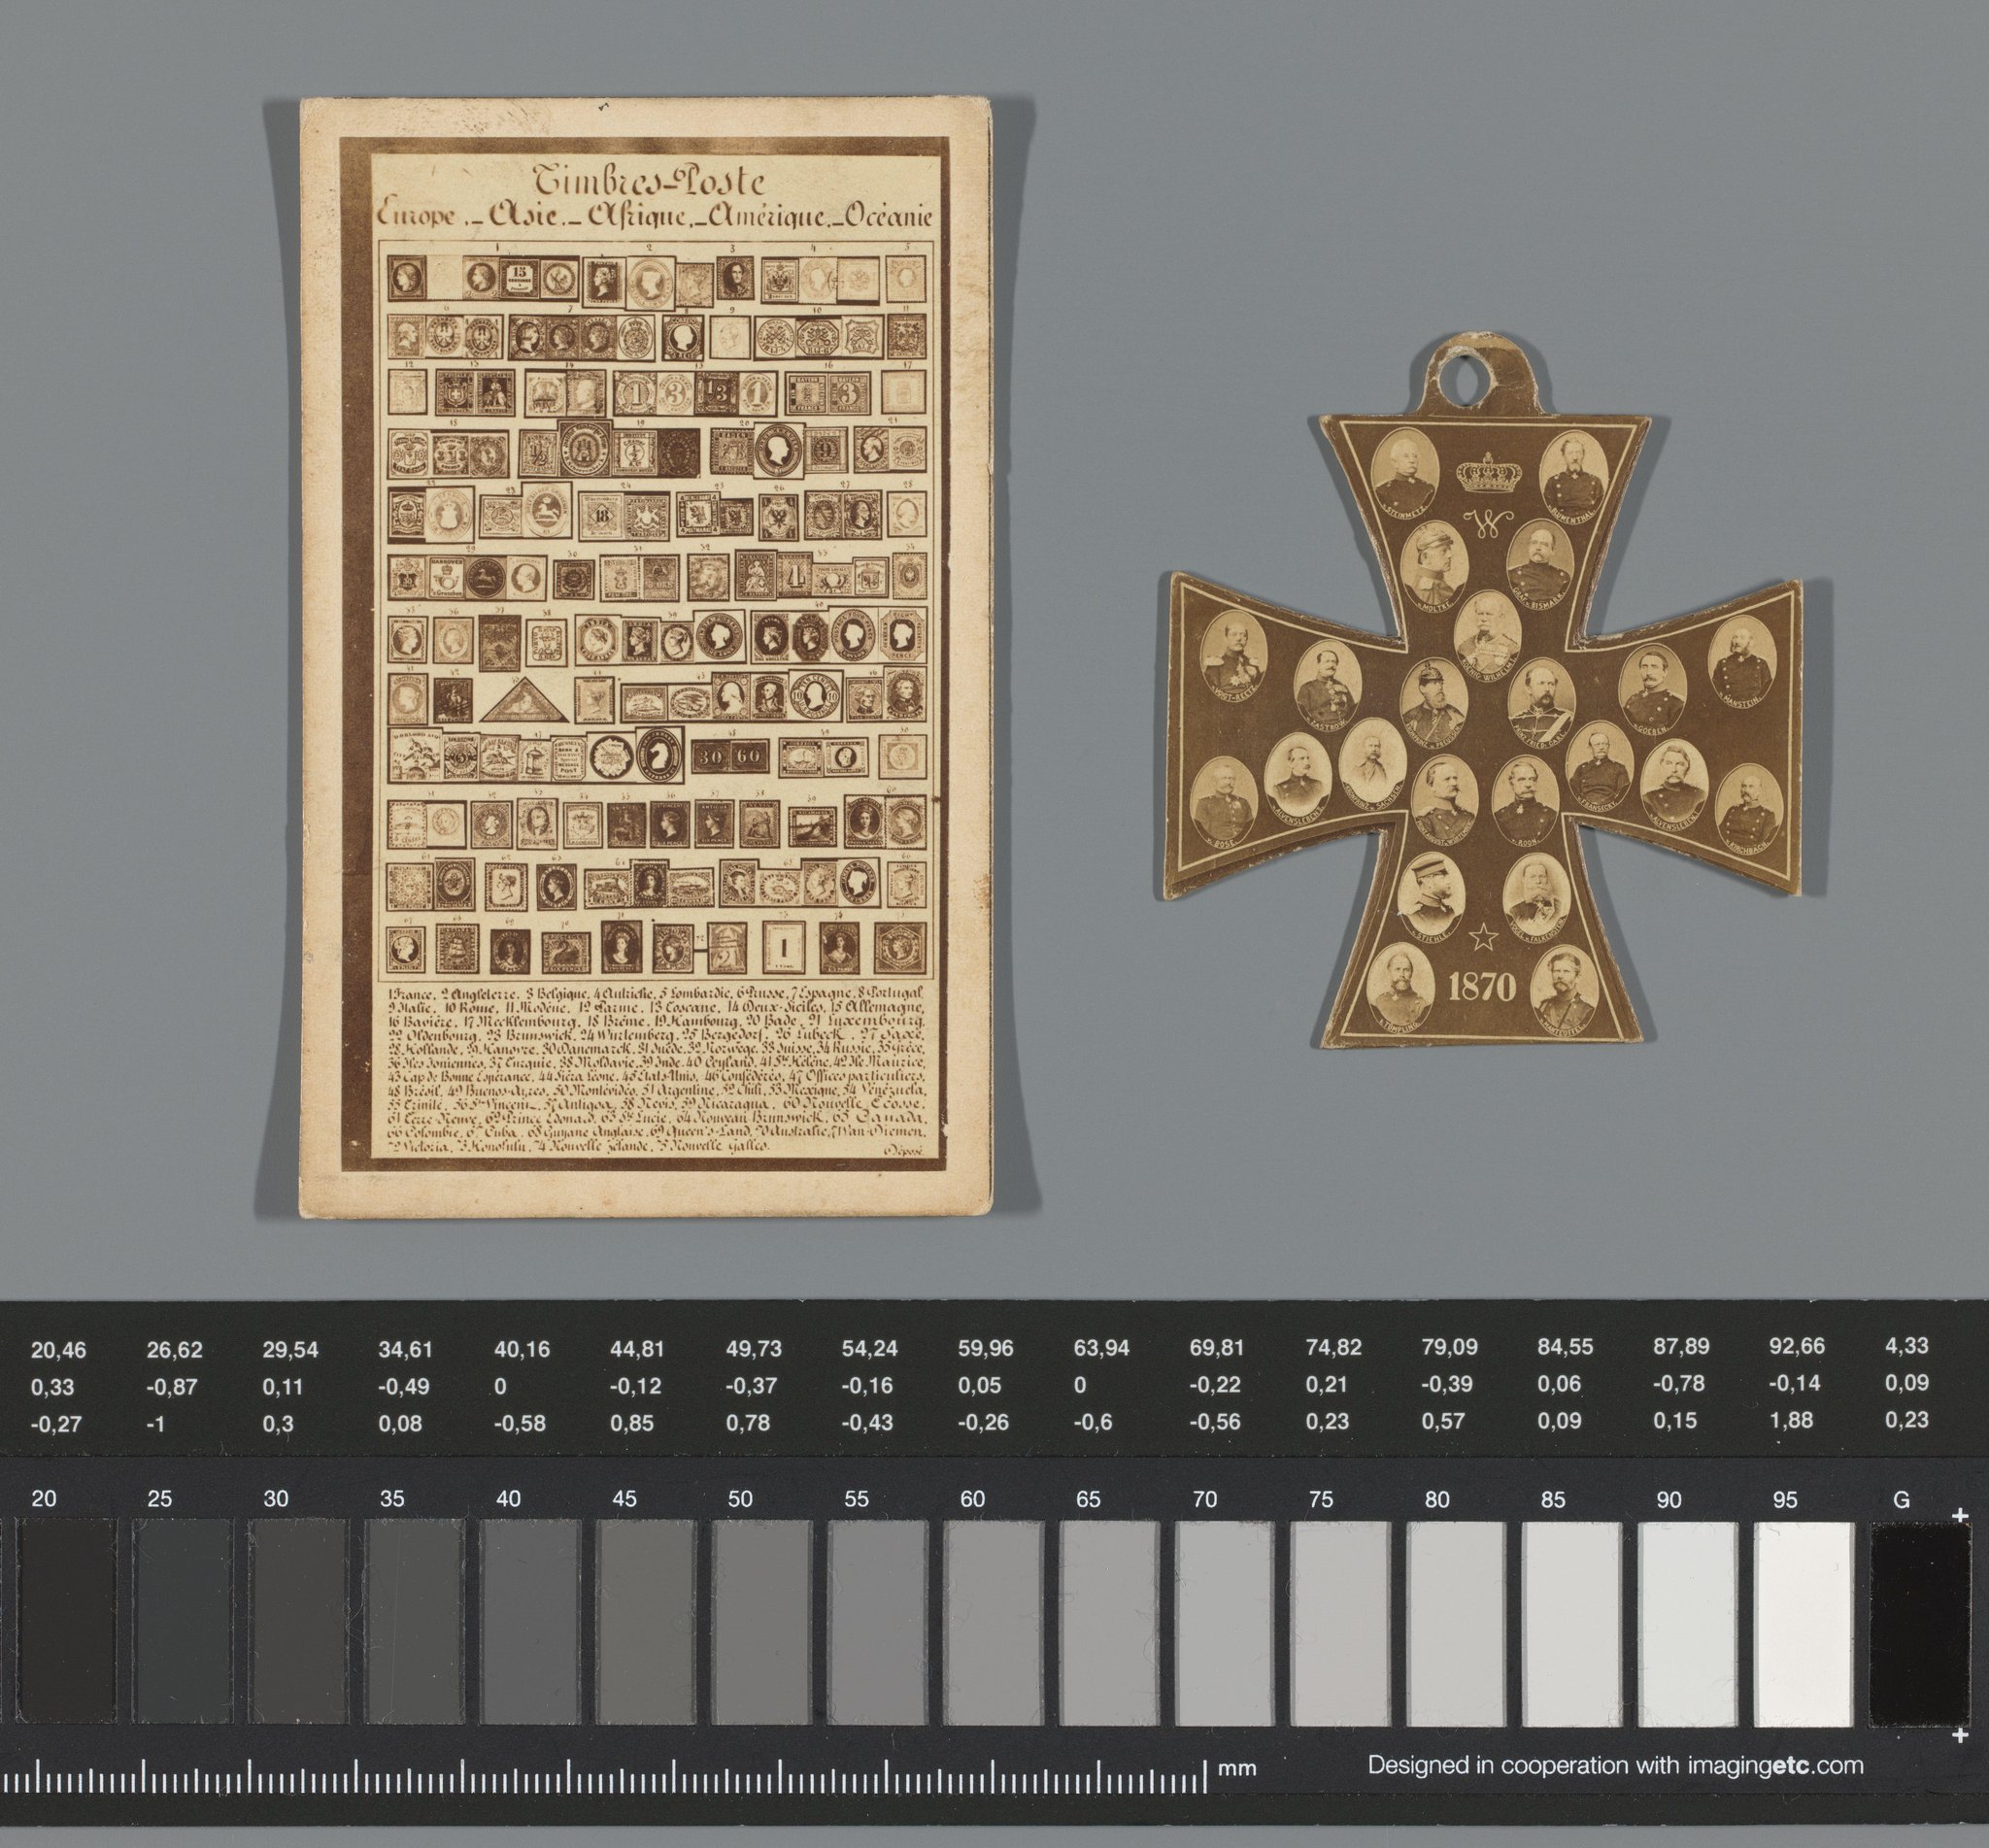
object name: carte de visite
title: Compositie met postzegels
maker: a. villeneuve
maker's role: fotograaf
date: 1855-1866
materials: cardboard, photographic support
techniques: albumen print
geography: paris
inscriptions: stamp: ‘’PHOTOGRAPHIE DE L’ORATOIRE / A. VILLENEUVE / Rue St. Honoré, 152 / Paris’, inscription: ‘Timbres-Poste / Europe – Asie – Afrique – Amérique – Oceanie’